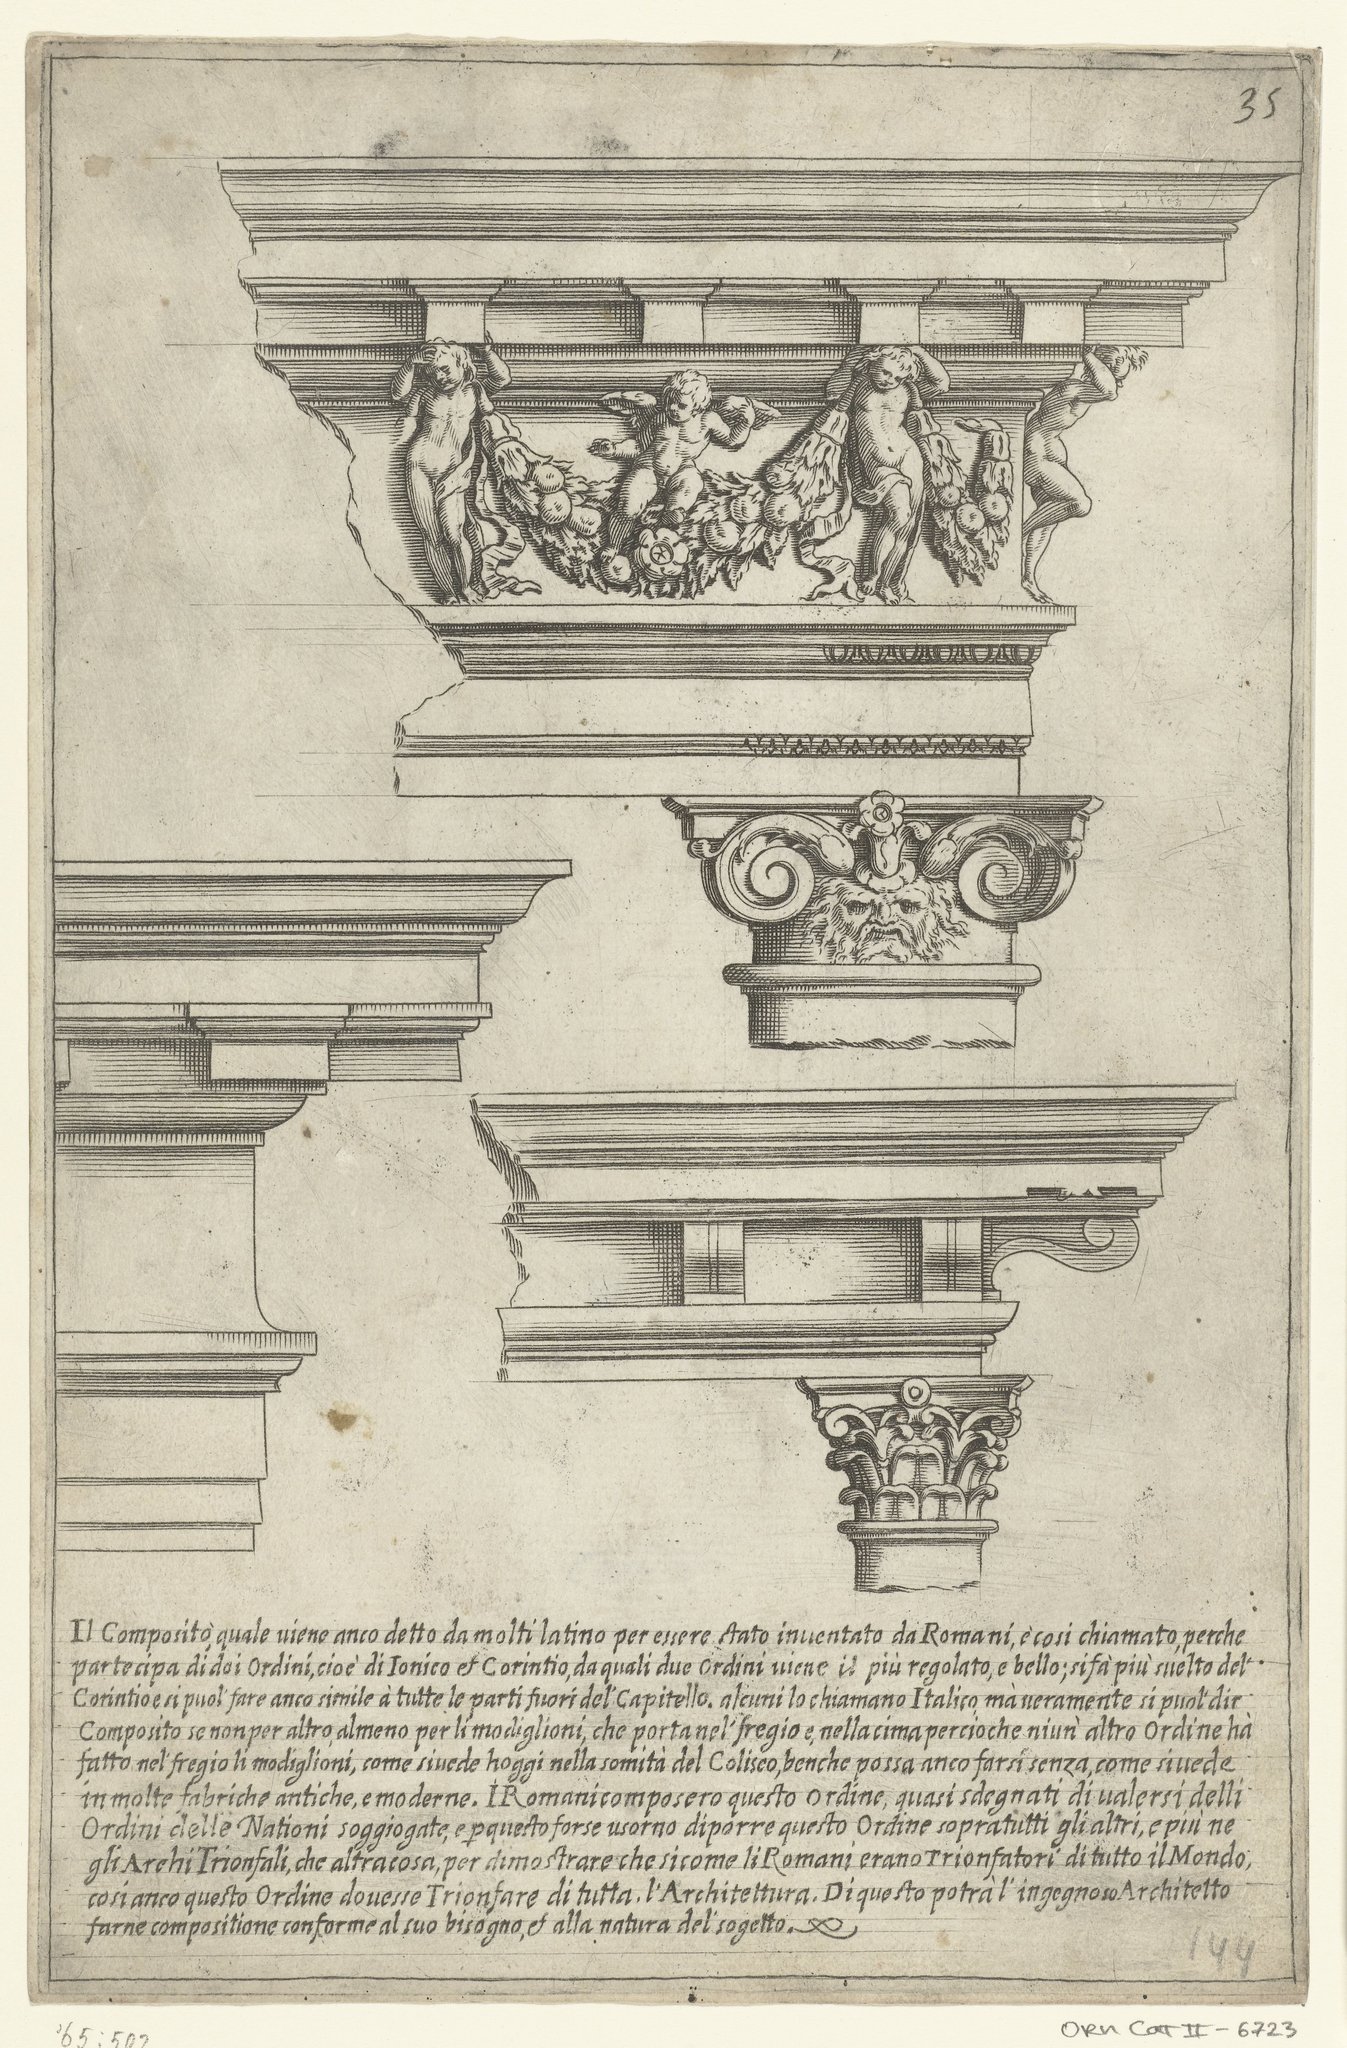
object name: ornament print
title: Architettura con diversi ornamenti cavati dall' Antico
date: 1636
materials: paper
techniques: engraving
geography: italy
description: Onderaan staat uitleg. Uit eerste editie.